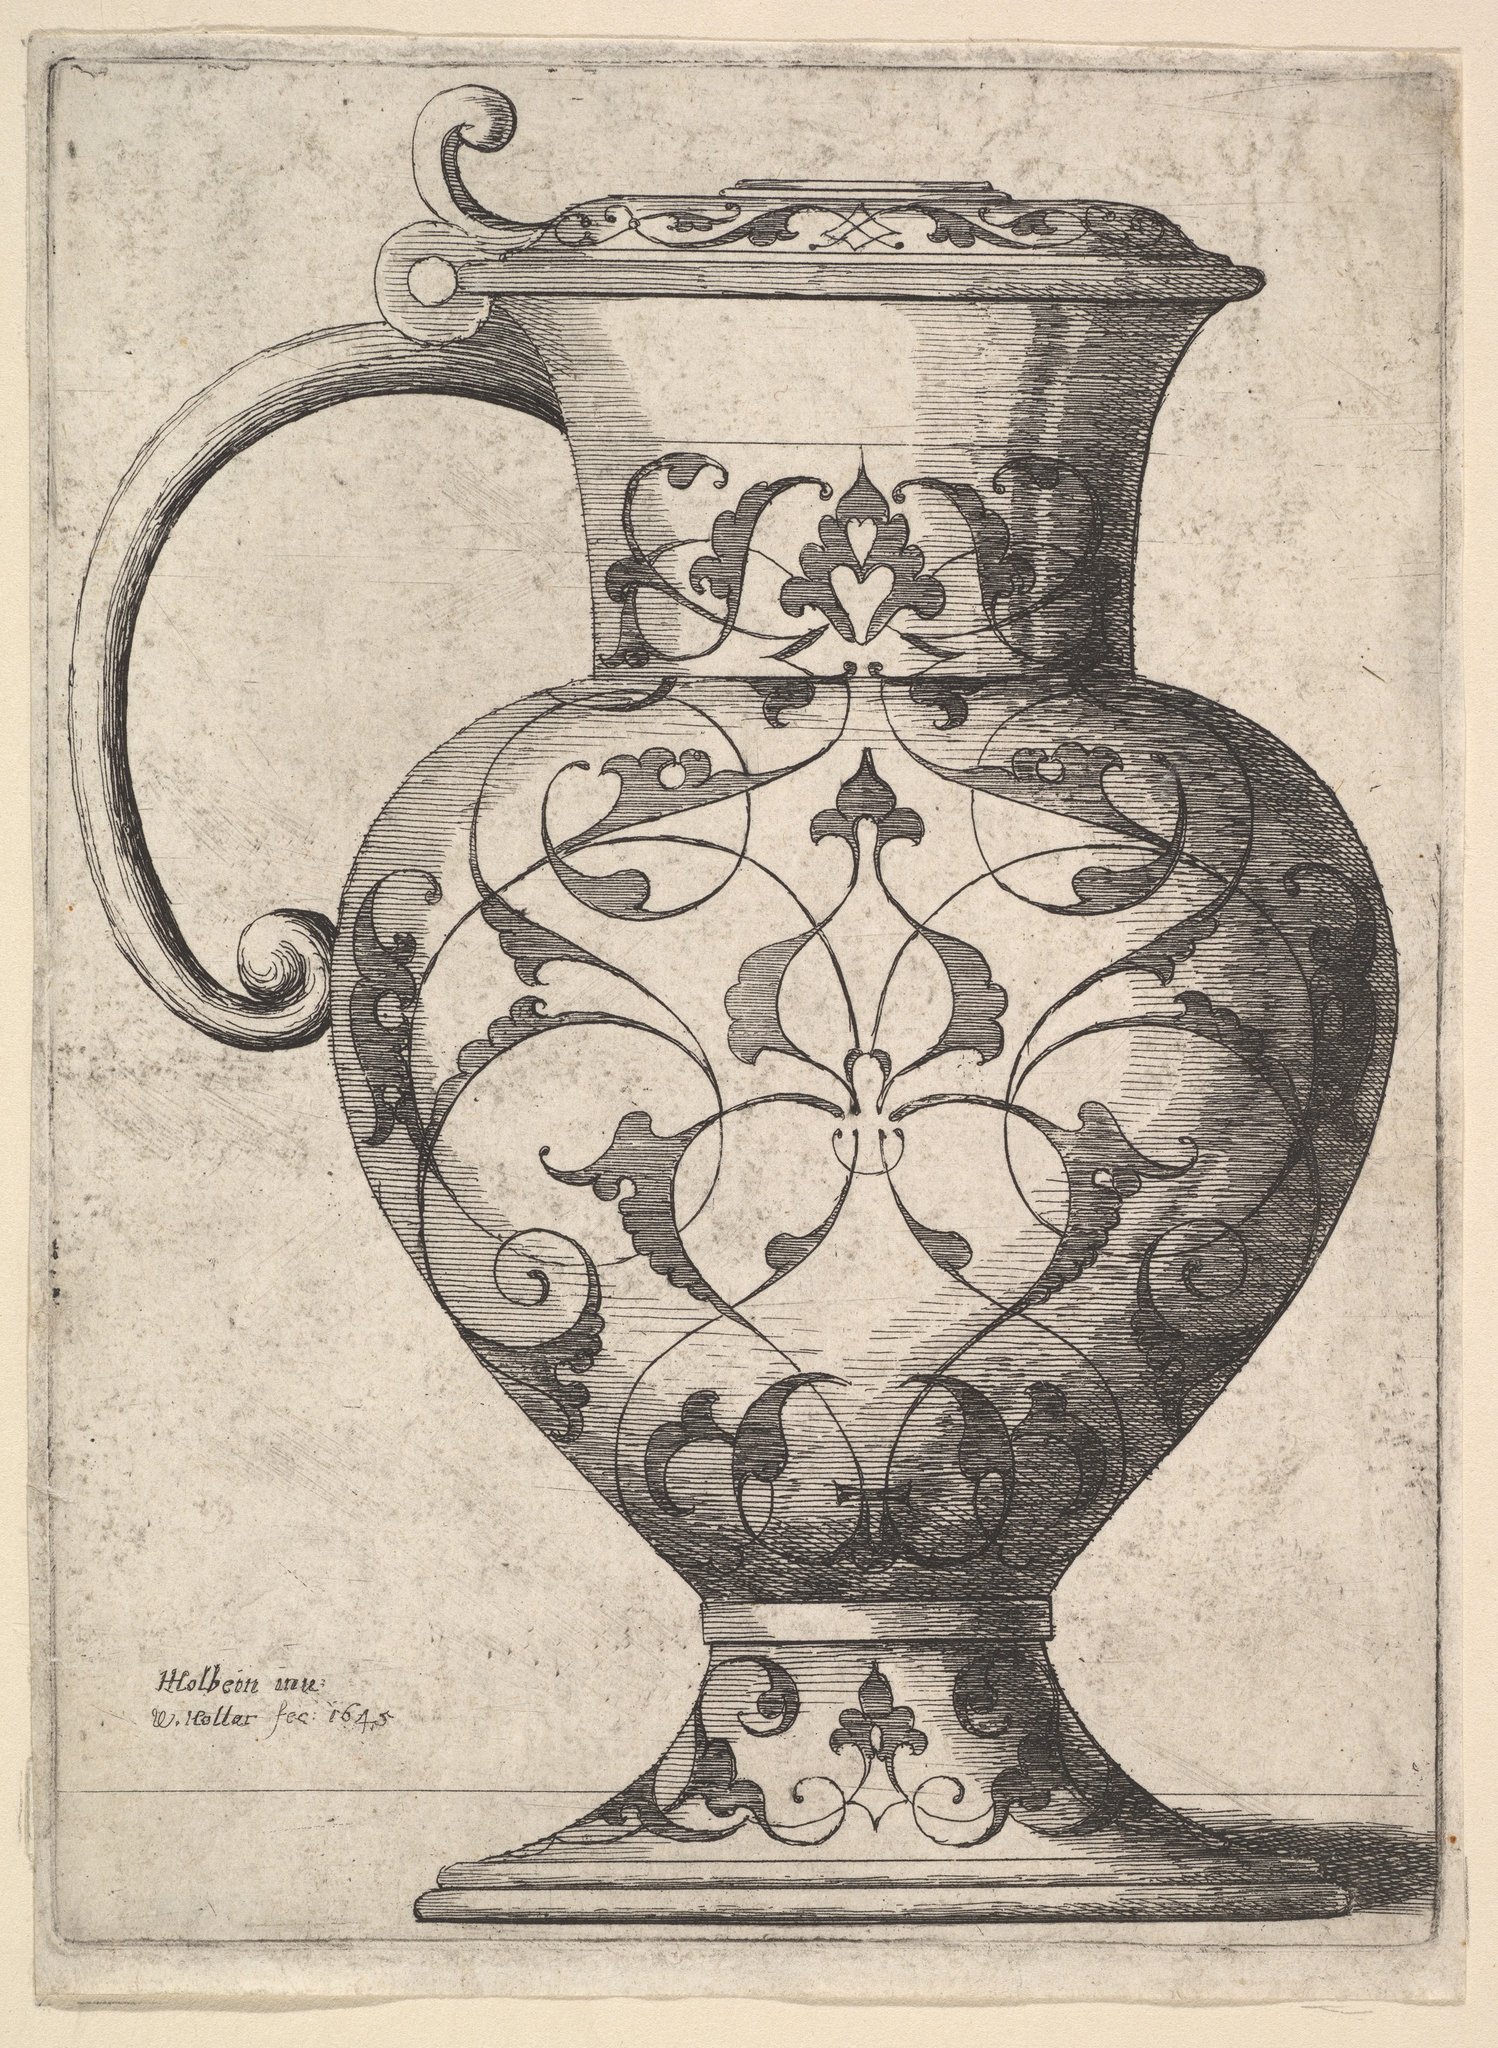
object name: print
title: Jug decorated with arabesques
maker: wenceslaus hollar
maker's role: artist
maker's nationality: bohemian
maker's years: 1607-1677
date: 1645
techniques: etching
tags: jugs